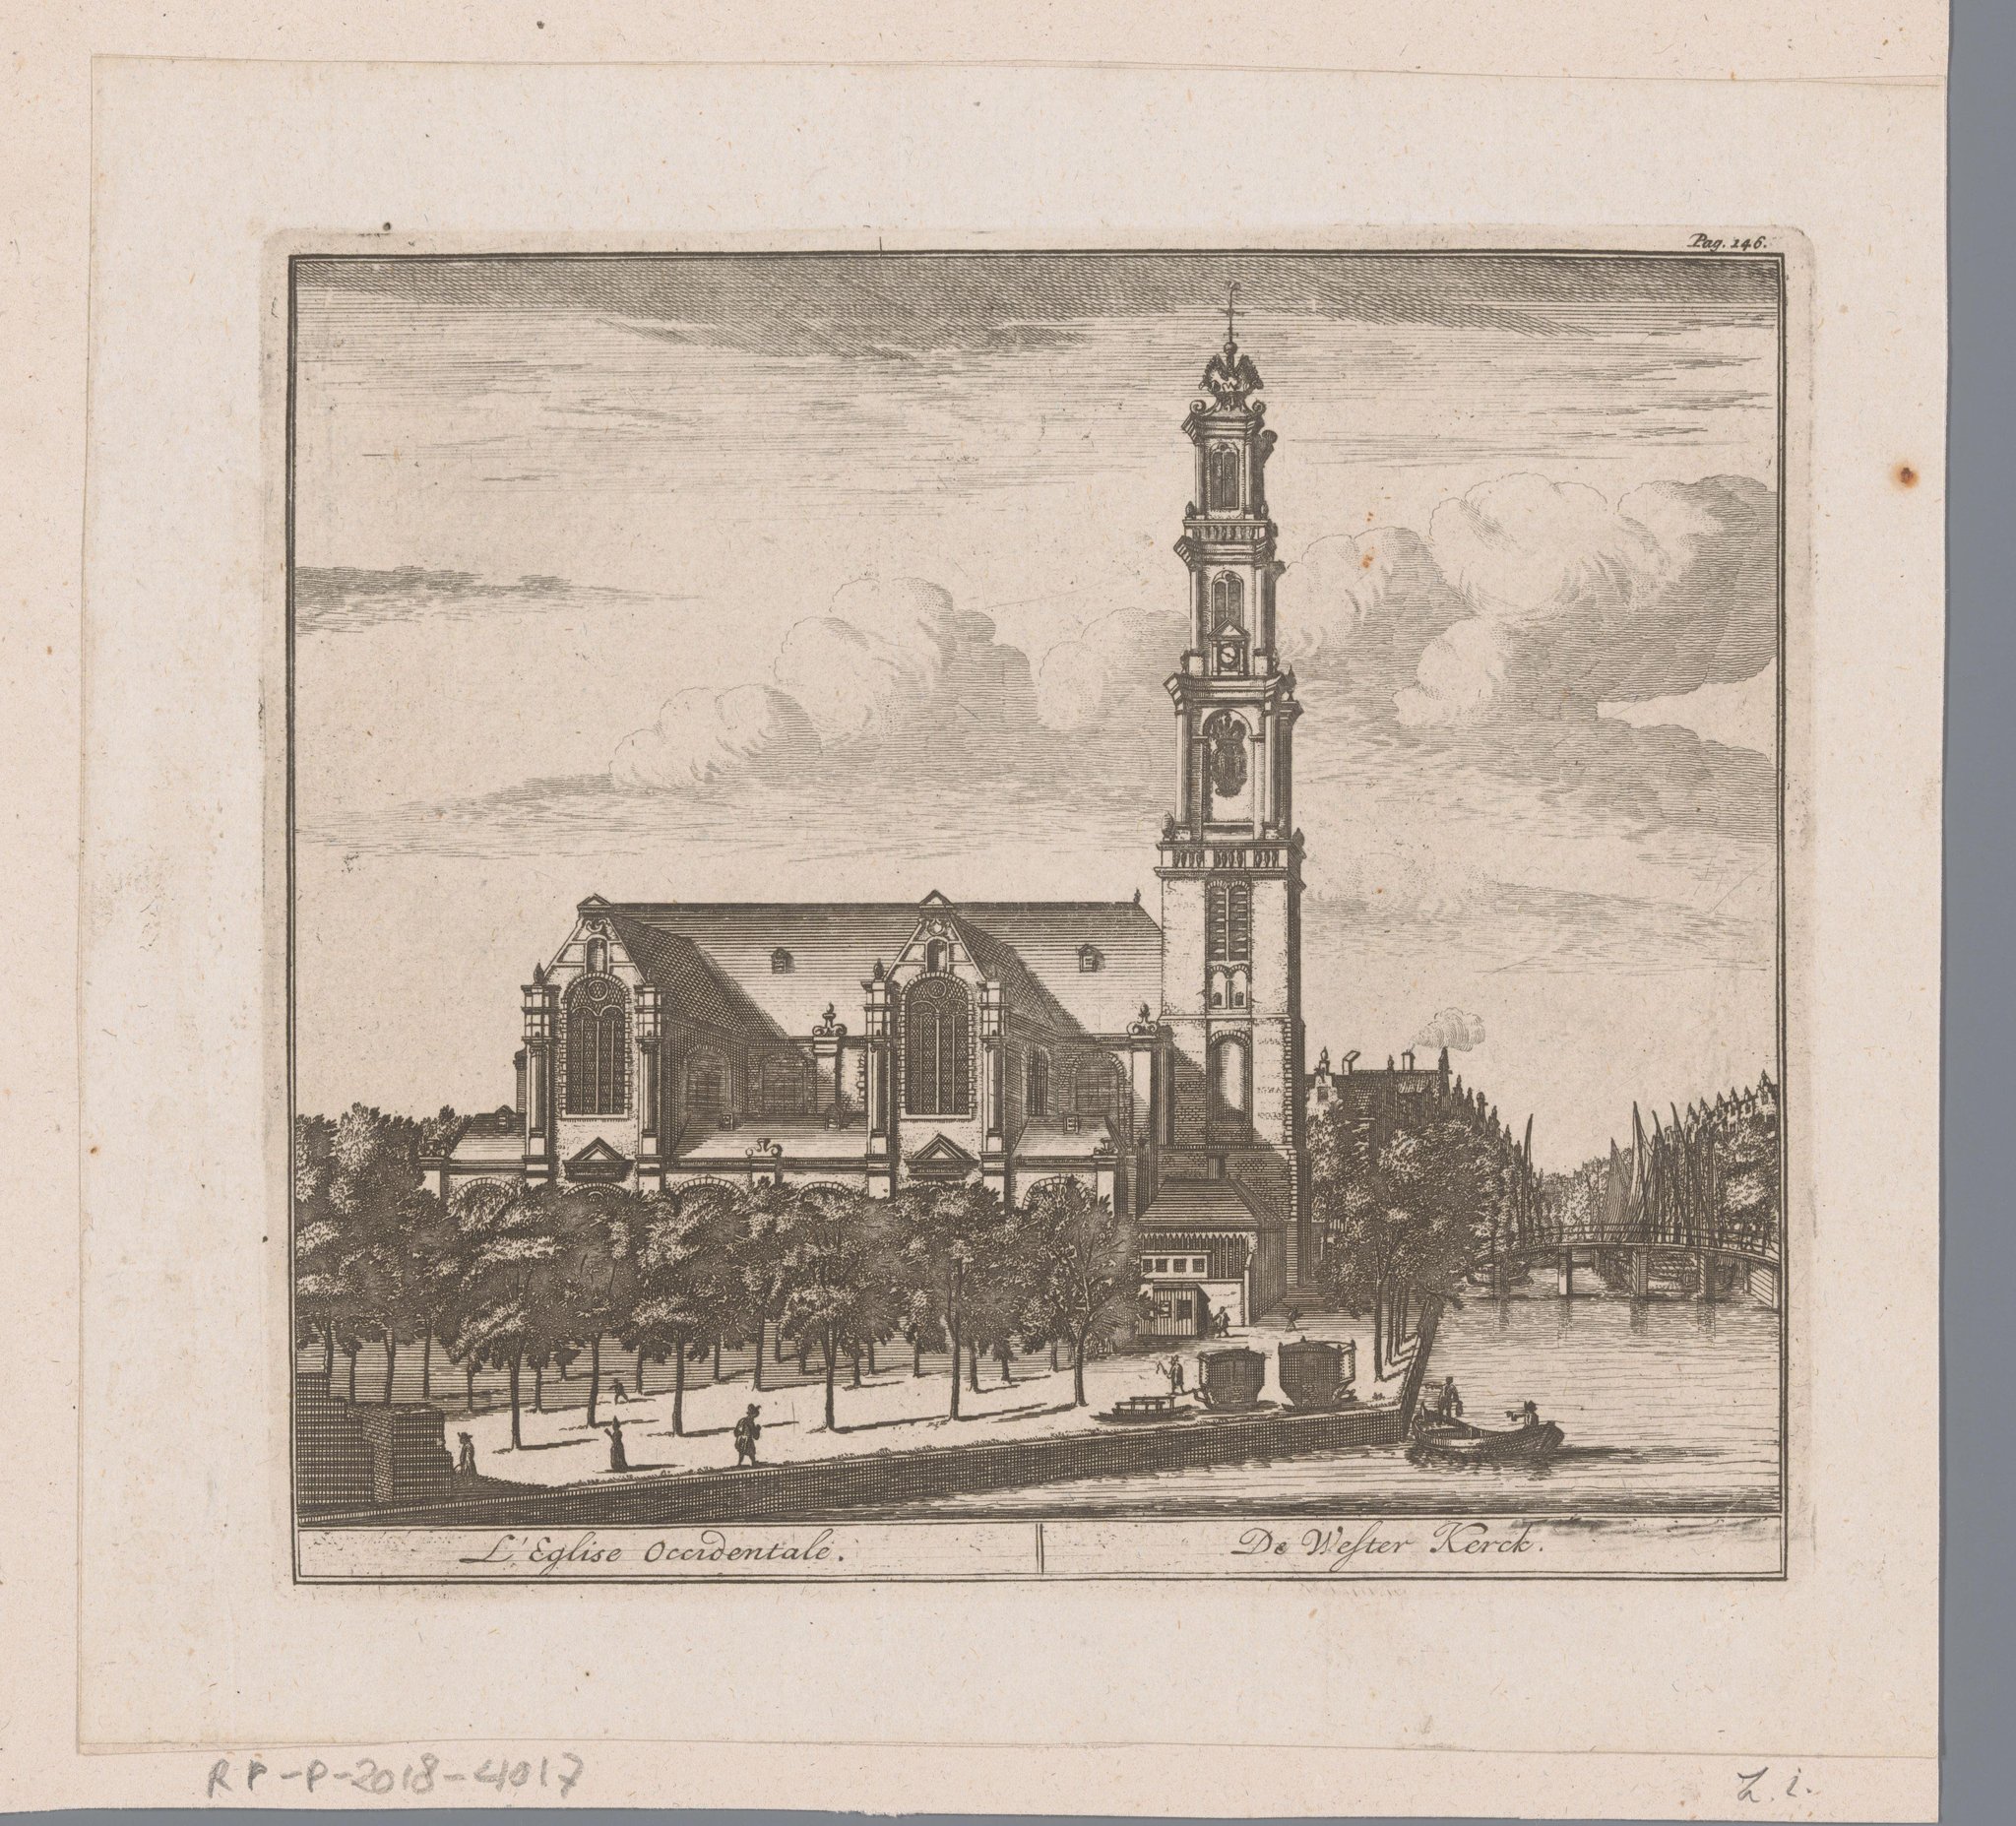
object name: print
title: Gezicht op de Westerkerk te Amsterdam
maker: Anonymous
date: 1680-1720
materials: paper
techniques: etching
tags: church (exterior), canals, waters (in city)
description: De huidige staat van deze prent komt waarschijnlijk uit: Le guide, ou nouvelle description d' Amsterdam; Enseignant aux voyageurs et aux negoçians (...). Amsterdam: Covens & Mortier, 1753. Een eerdere staat, ongenummerd, komt mogelijk uit een eerdere editie van deze publicatie. De eerst bekende staat van deze prent, met signatuur (Daniël Stopendaal) en enkel Nederlands onderschrift (De Wester Kerck) komt mogelijk uit een vooralsnog onbekende publicatie.